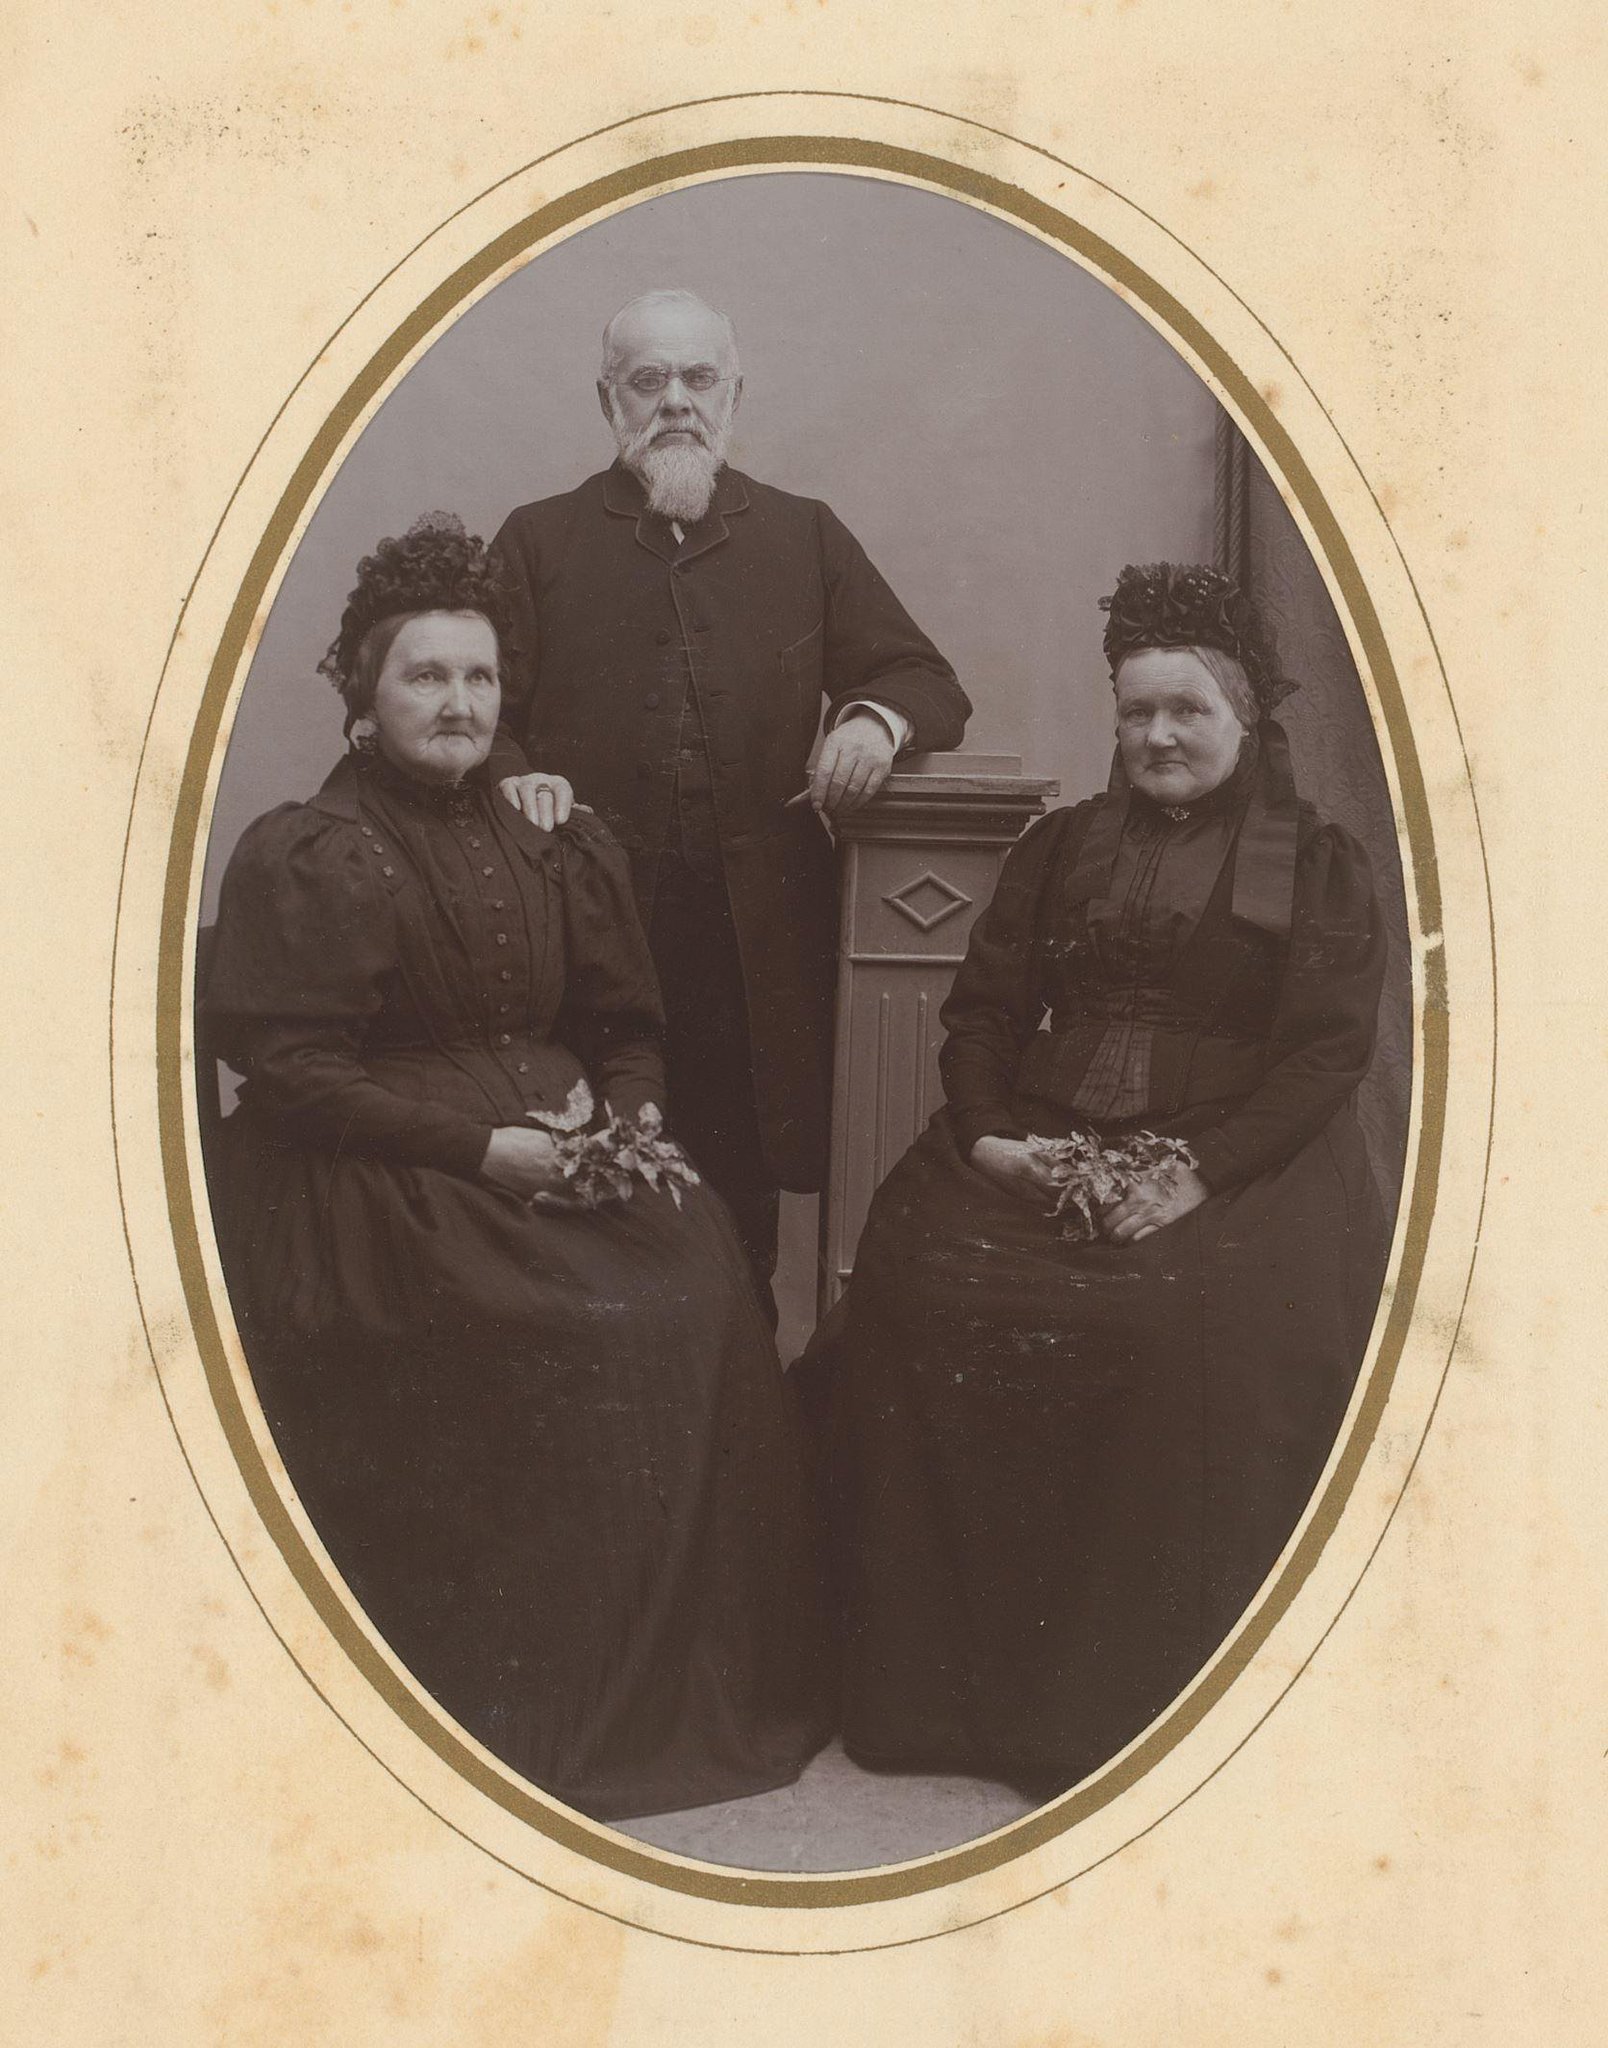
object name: cabinet photograph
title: Portret van een staande man en twee zittende vrouwen, allen in zwart gekleed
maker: pieter duiker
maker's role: fotograaf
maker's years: 1853-1936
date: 1878-1936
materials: cardboard, photographic support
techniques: collodion silver print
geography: hoogezand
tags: sitting figure - aa - female human figure (+ two persons), standing figure, anonymous historical persons portrayed in a group, in a group-portrait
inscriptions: inscription: ‘P. Duiker - photograaf - Hoogezand’